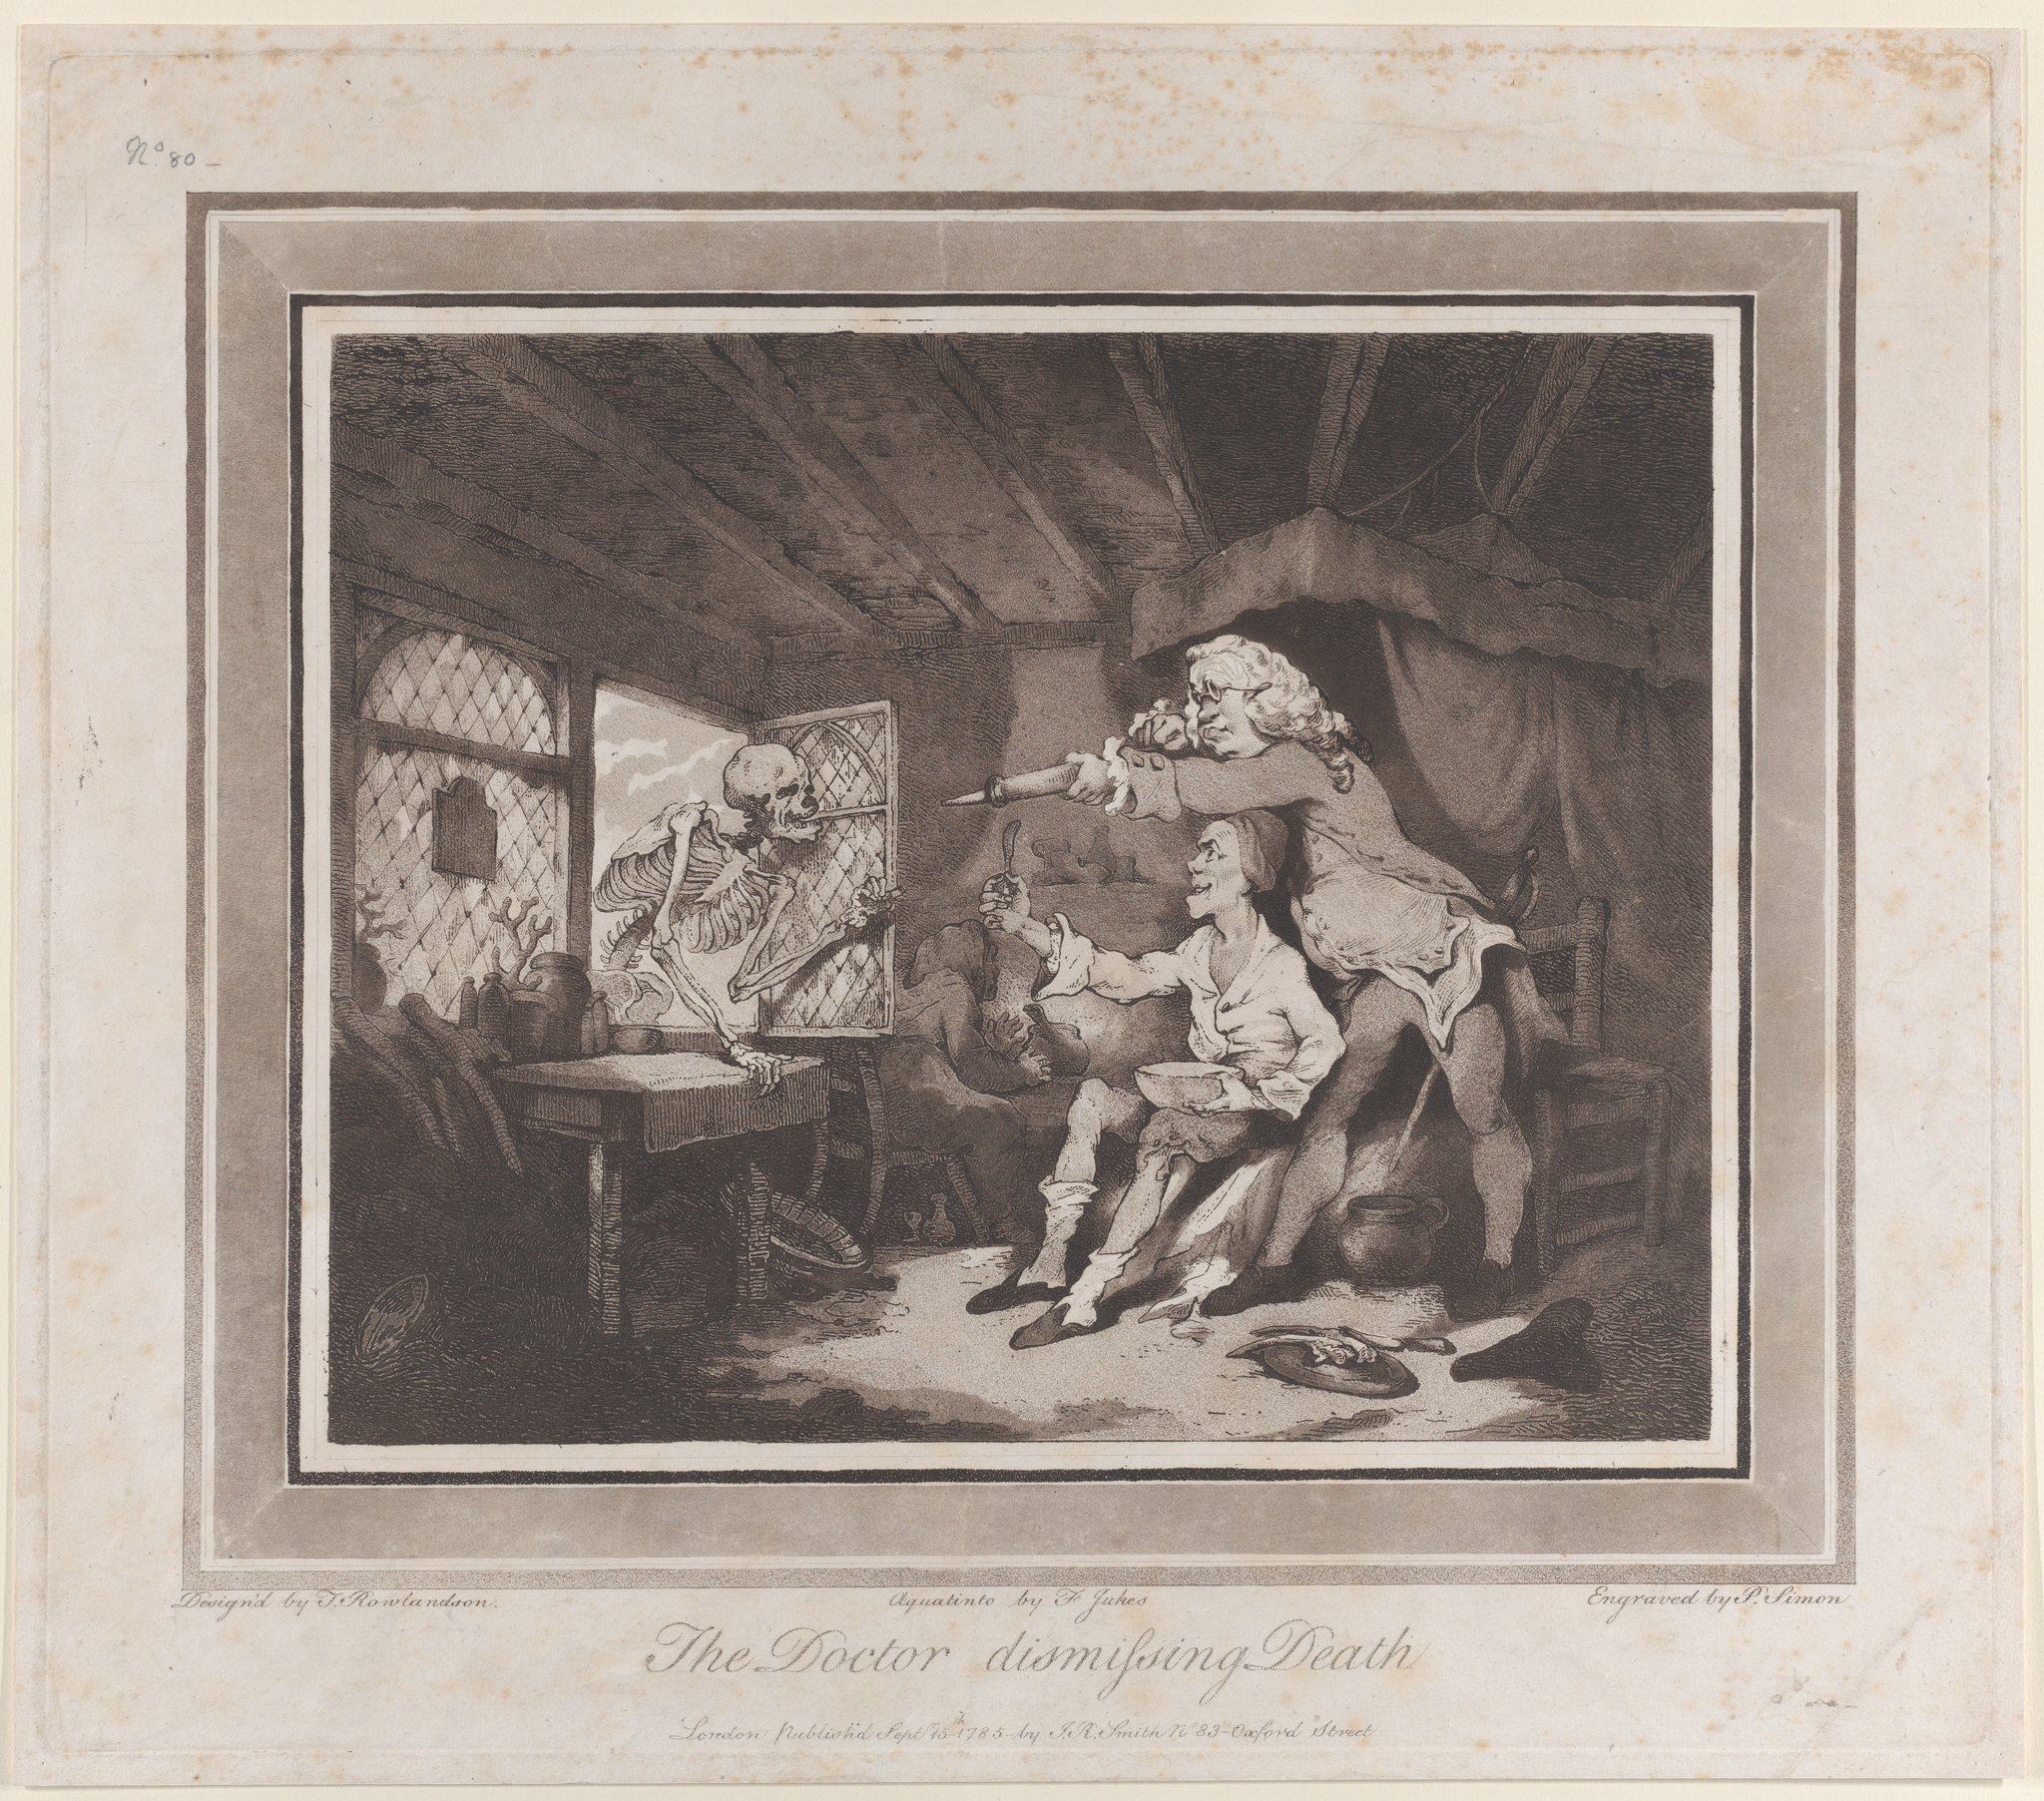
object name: print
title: The Doctor Dismissing Death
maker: peter simon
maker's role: artist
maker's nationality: british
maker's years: 1764-1813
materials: ink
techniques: aquatint, etching, printing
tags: interiors,skeletons,men